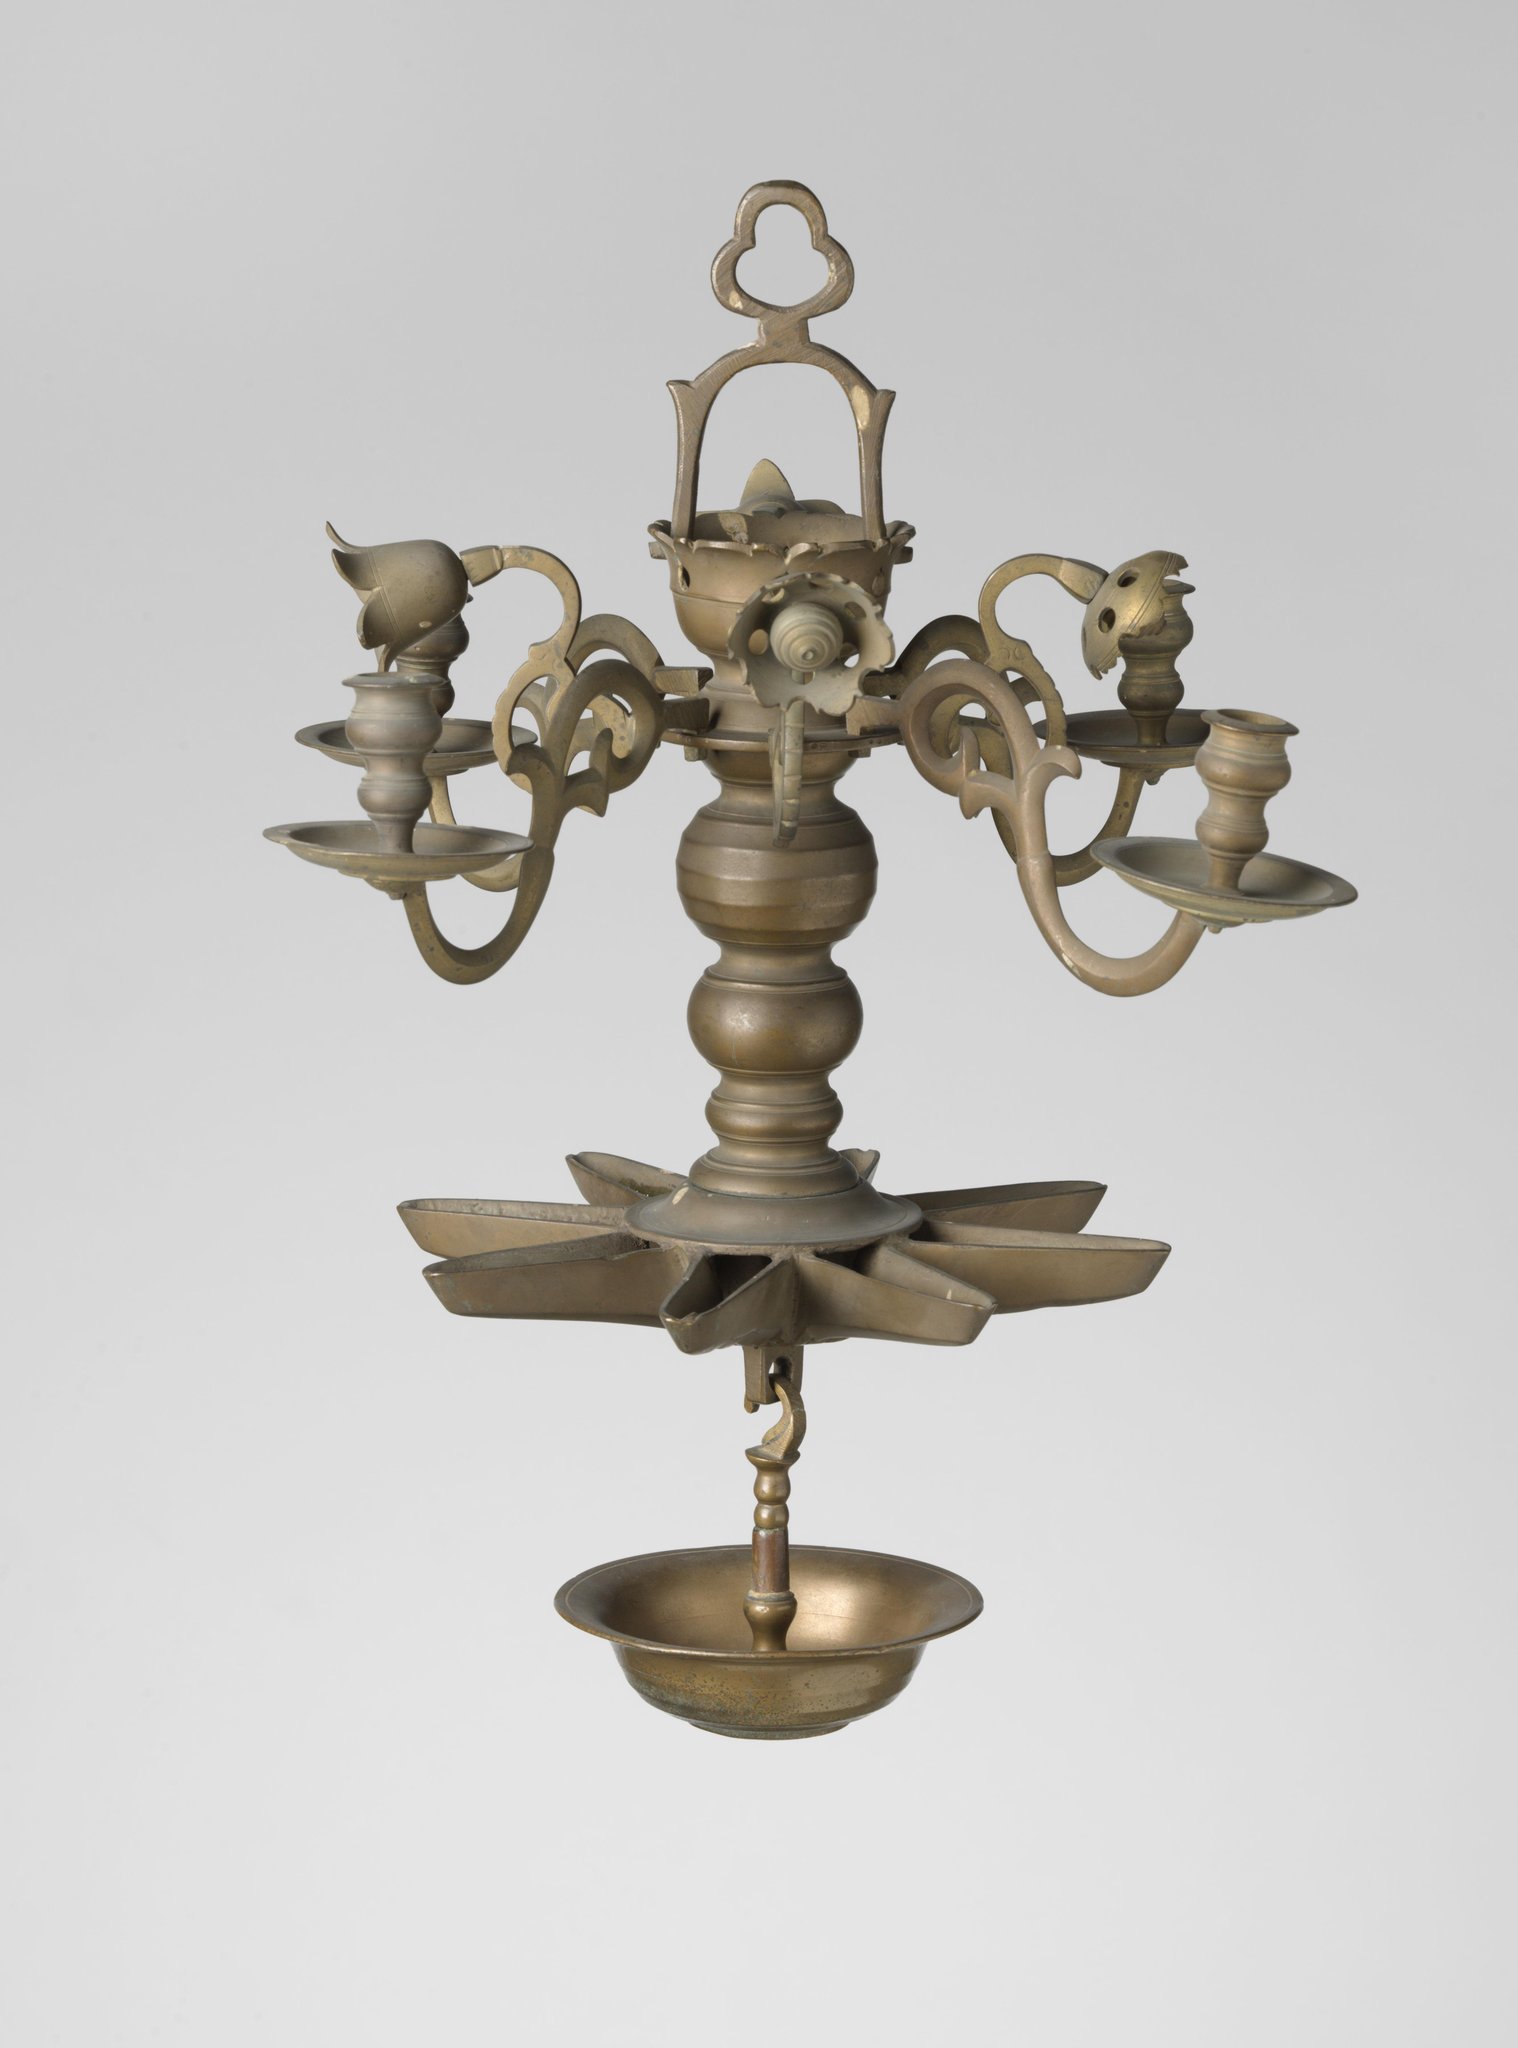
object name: sabbath lamp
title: Arm van sabbathlamp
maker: Anonymous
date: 1700-1800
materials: brass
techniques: casting, screwed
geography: nuremberg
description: Arm van een sabbathlamp. De S-vormige arm eindigt naar de stam toe in een krul en gaat naar buiten toe over in een plat bevestigingsdeel, waarin de bol- en holronde zich naar de voet verjongende houder op de geprofileerde ronde vetvanger is geschroefd. Dit is de tweede arm, genummerd met 2 ronde punten.